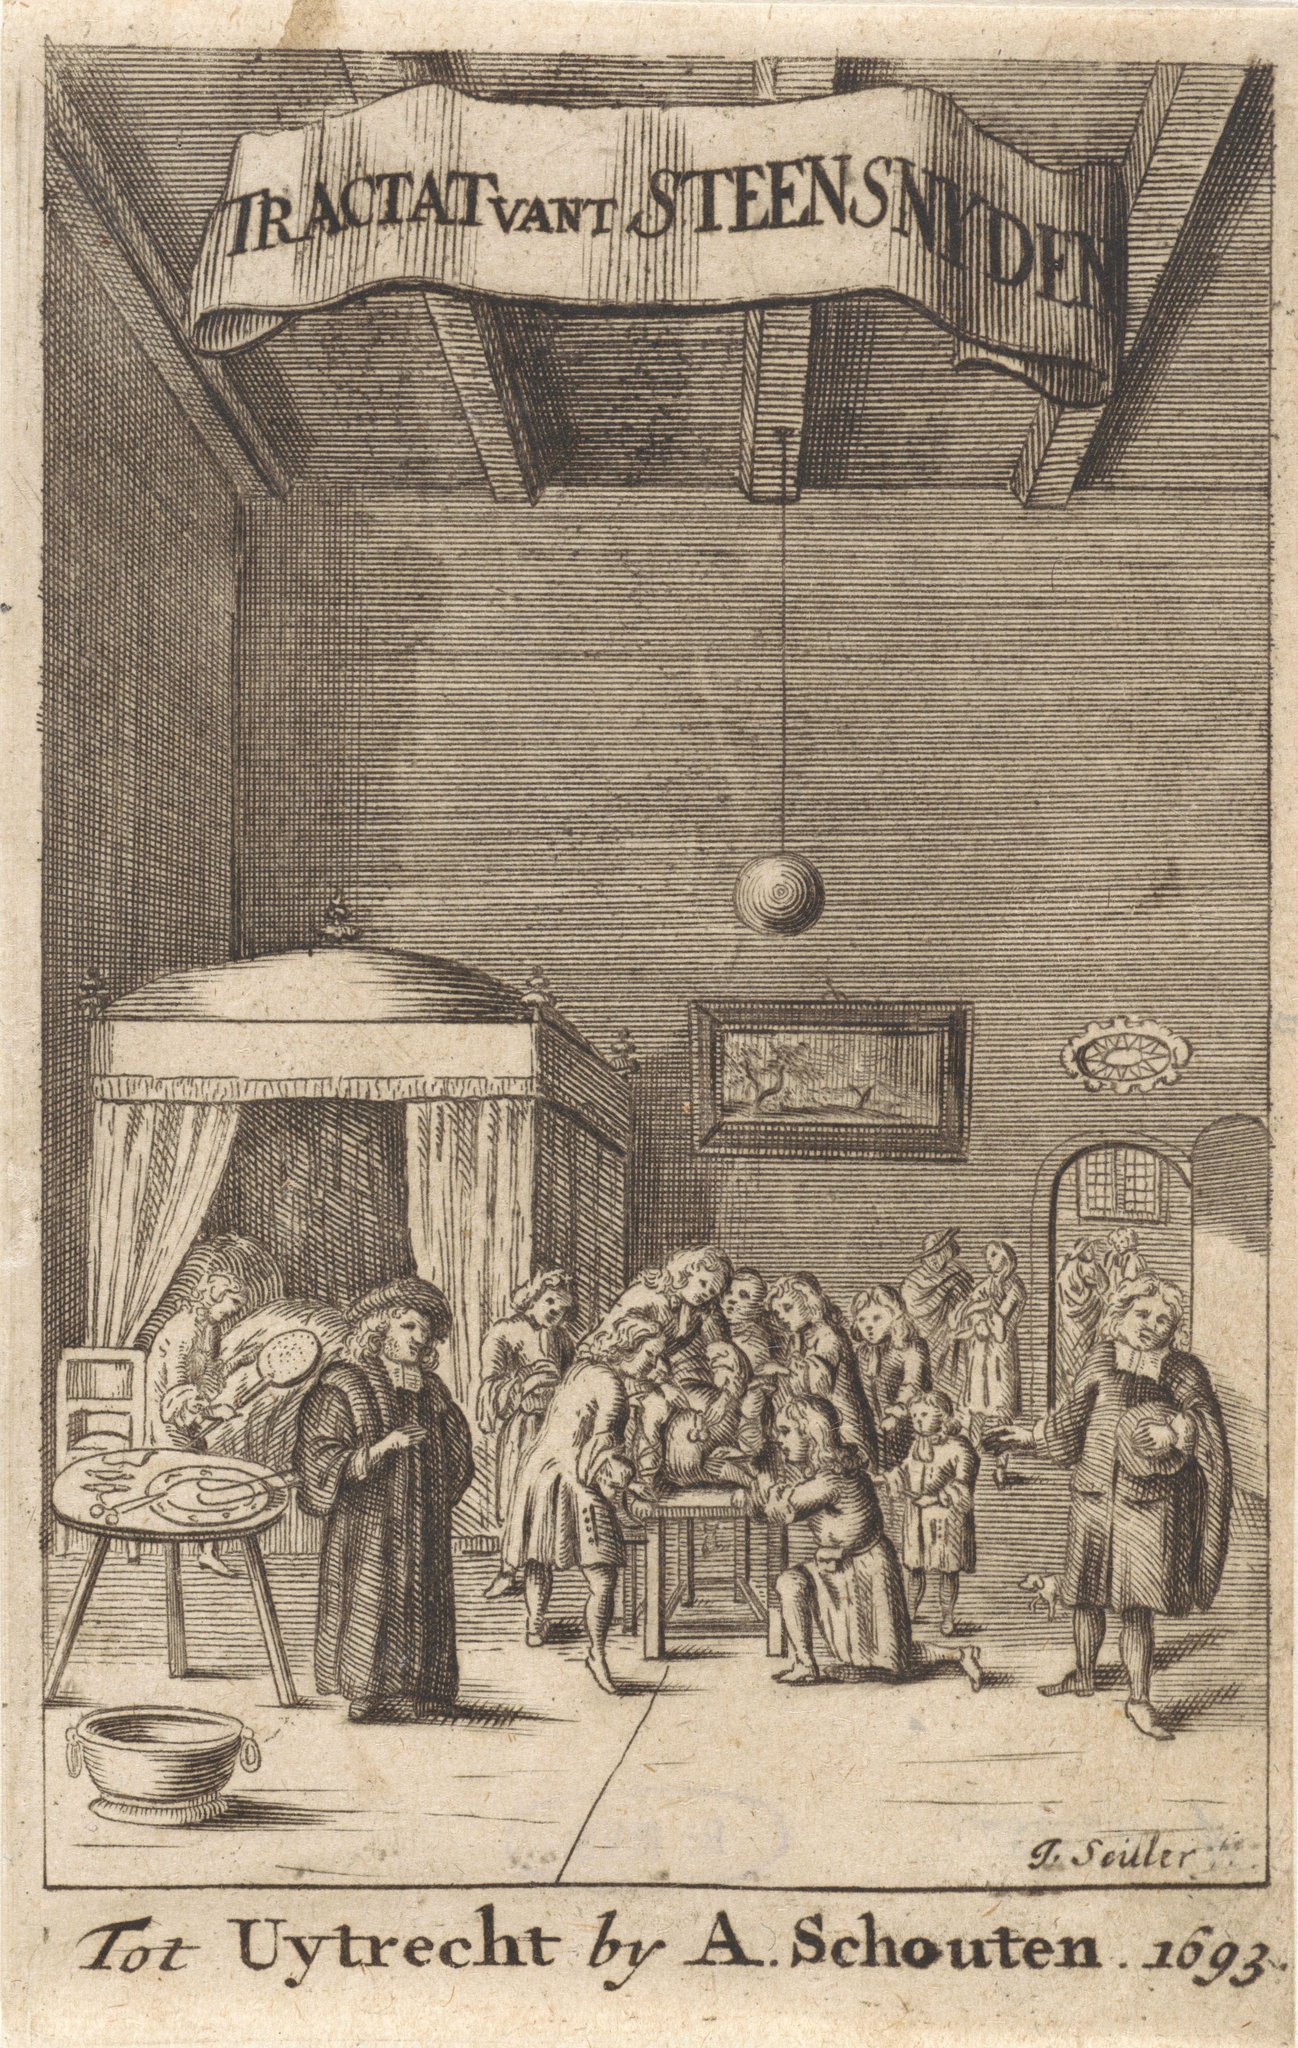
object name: print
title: Operatie in ziekenkamer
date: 1693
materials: paper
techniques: engraving, etching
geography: utrecht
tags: operation, surgery, four poster bed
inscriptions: collector's mark: Lugt 2228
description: Een groep mensen mensen kijkt toe hoe een patient, vastgebonden op een tafel, verlost wordt van zijn blaasstenen. Op een andere tafel liggen de operatiebenodigdheden klaar. Op de achtergrond een hemelbed.